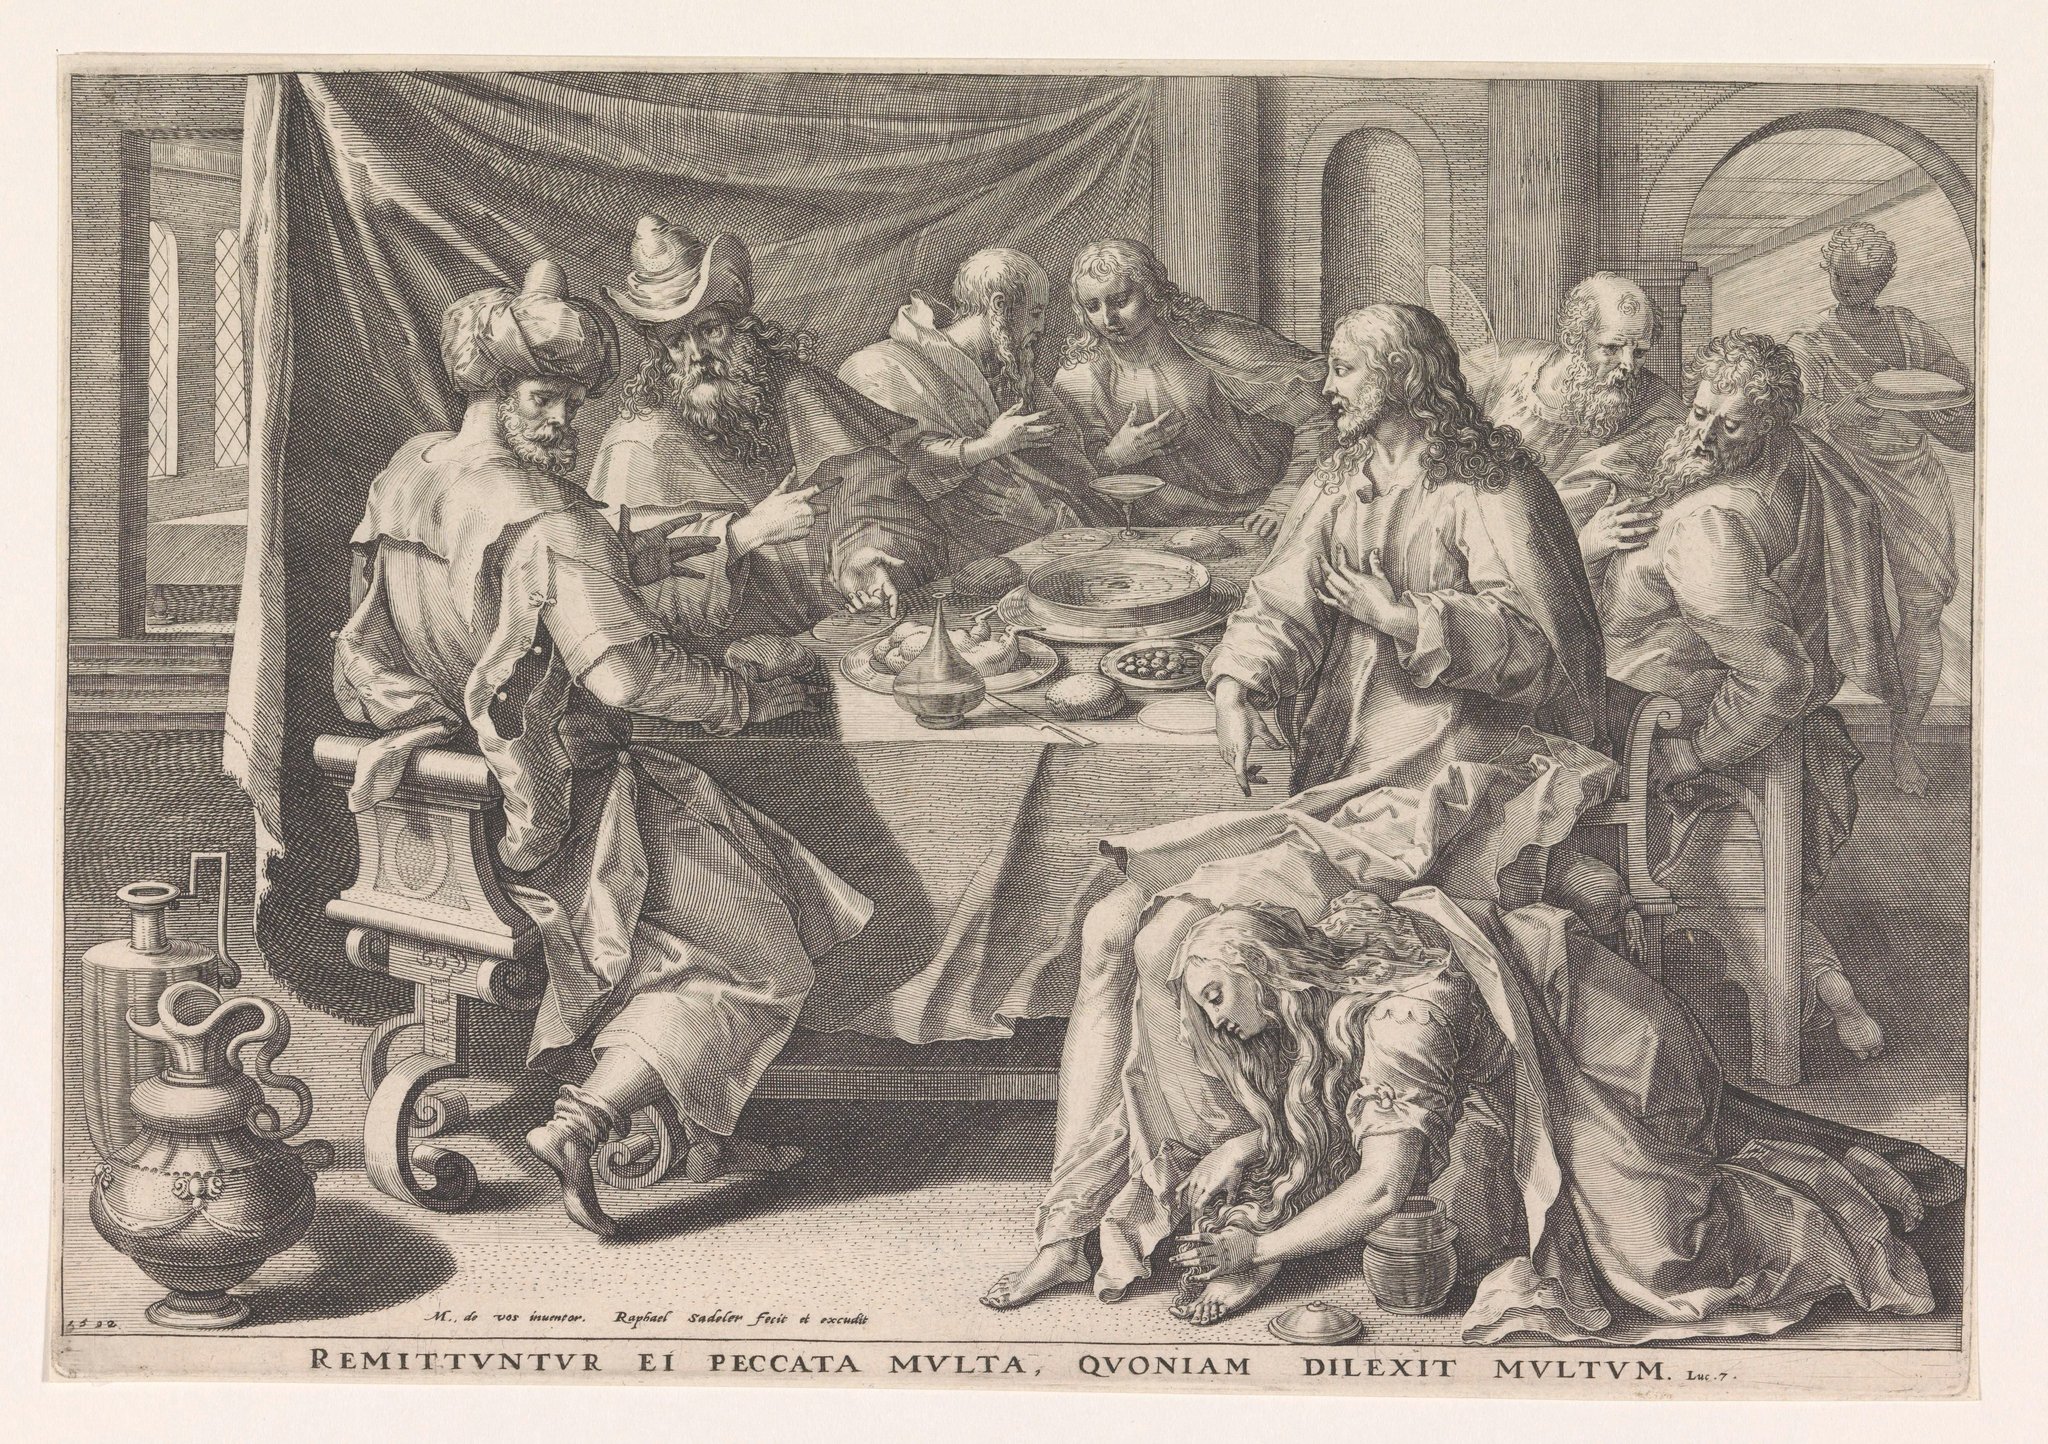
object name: print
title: Maria Magdalena wast de voeten van Christus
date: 1592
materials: paper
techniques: engraving, etching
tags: a woman washes christ's feet with her tears, and wipes them with her hair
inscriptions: collector's mark: Lugt 2228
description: Een interieur van een huis met op de voorgrond Christus en zijn leerlingen aan een tafel. Maria Magdalena, een lichtekooi, droogt de voeten van Christus met haar haren. Ze gaat vervolgens de voeten zalven. Judas Iskariot protesteert, maar Christus legt uit dat men haar moet vergeven.